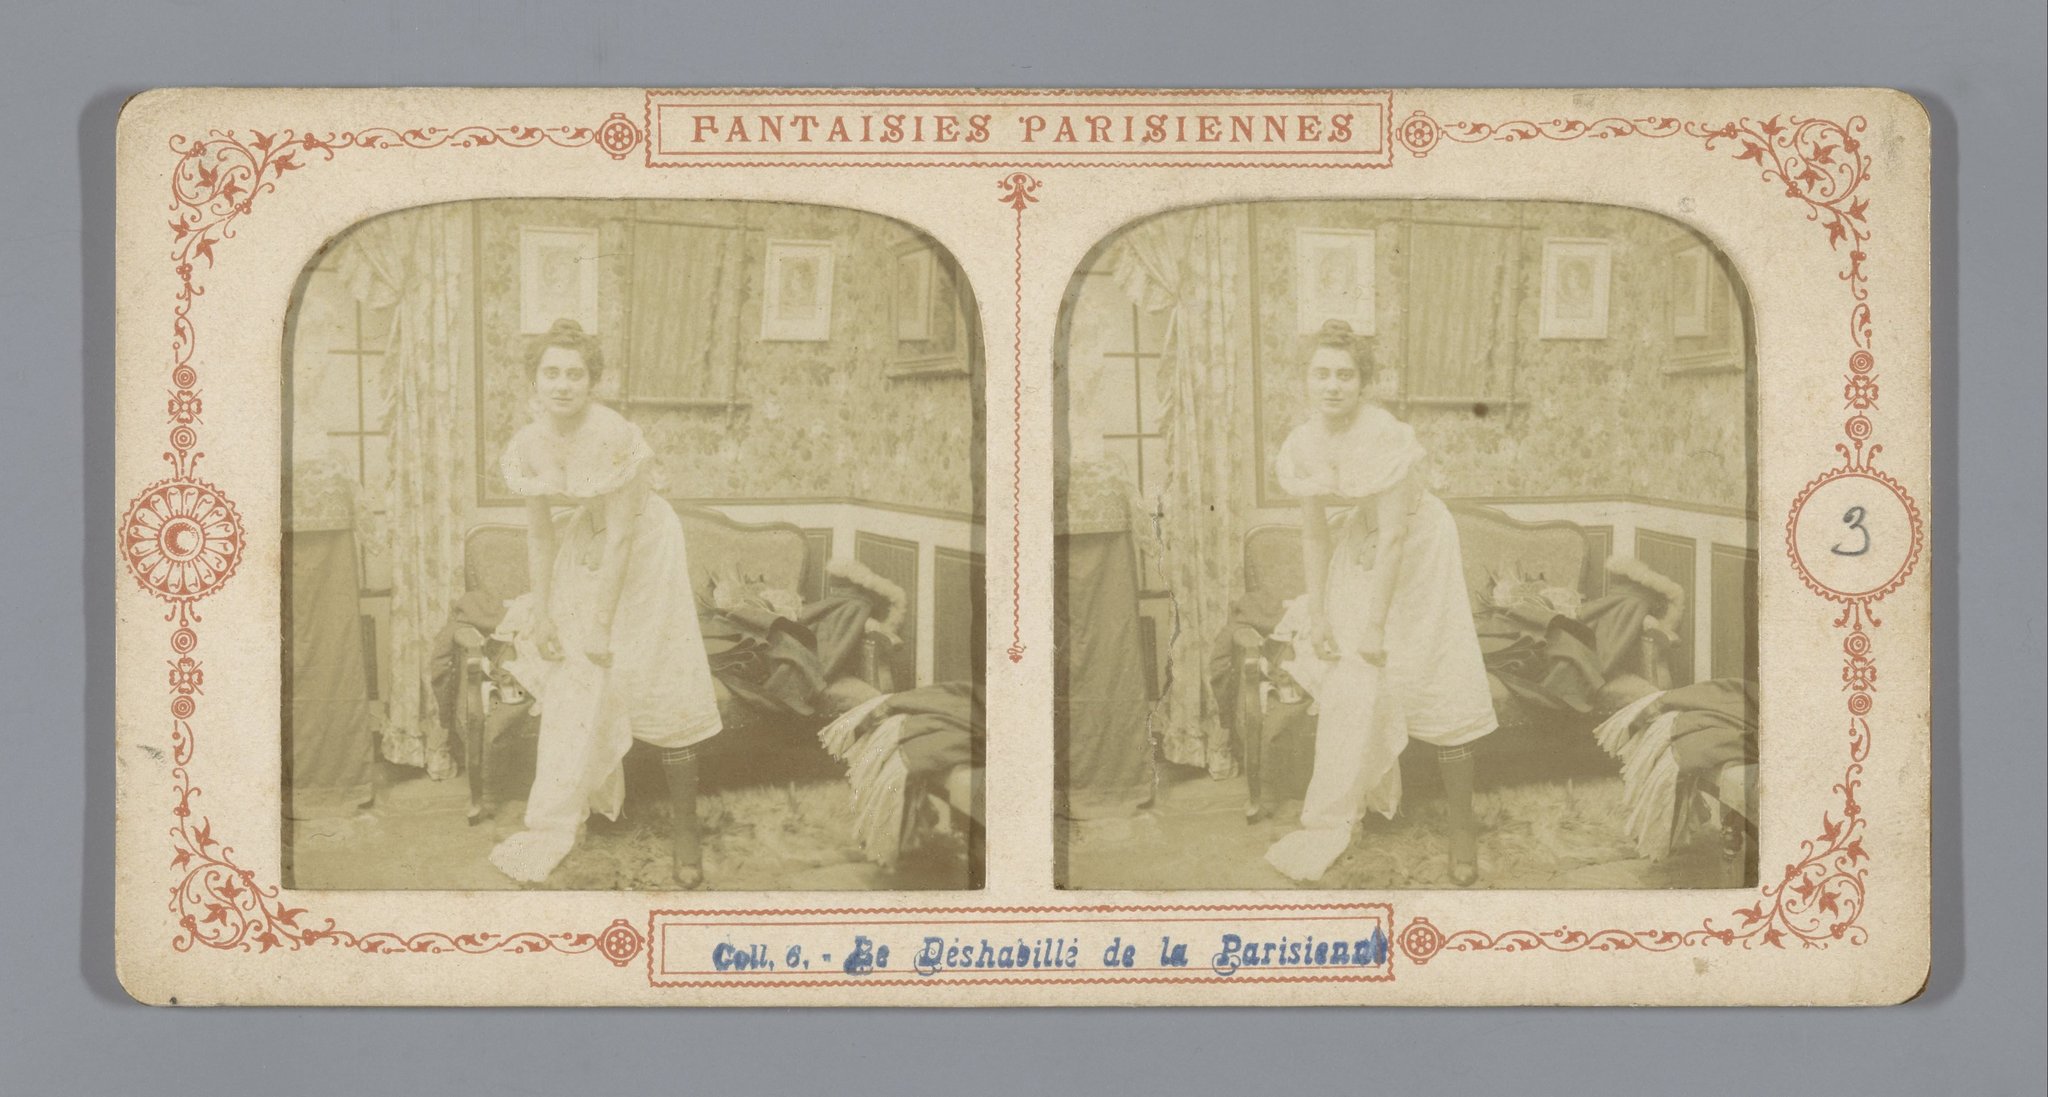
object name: tissue stereograph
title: Le Déshabillé de la Parisienne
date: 1855-1875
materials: cardboard, paper, photographic support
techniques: albumen print, cutting, hand coloring, perforating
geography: france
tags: adult woman, paris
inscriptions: number: ‘3’, inscription: ‘Coll. 6.’